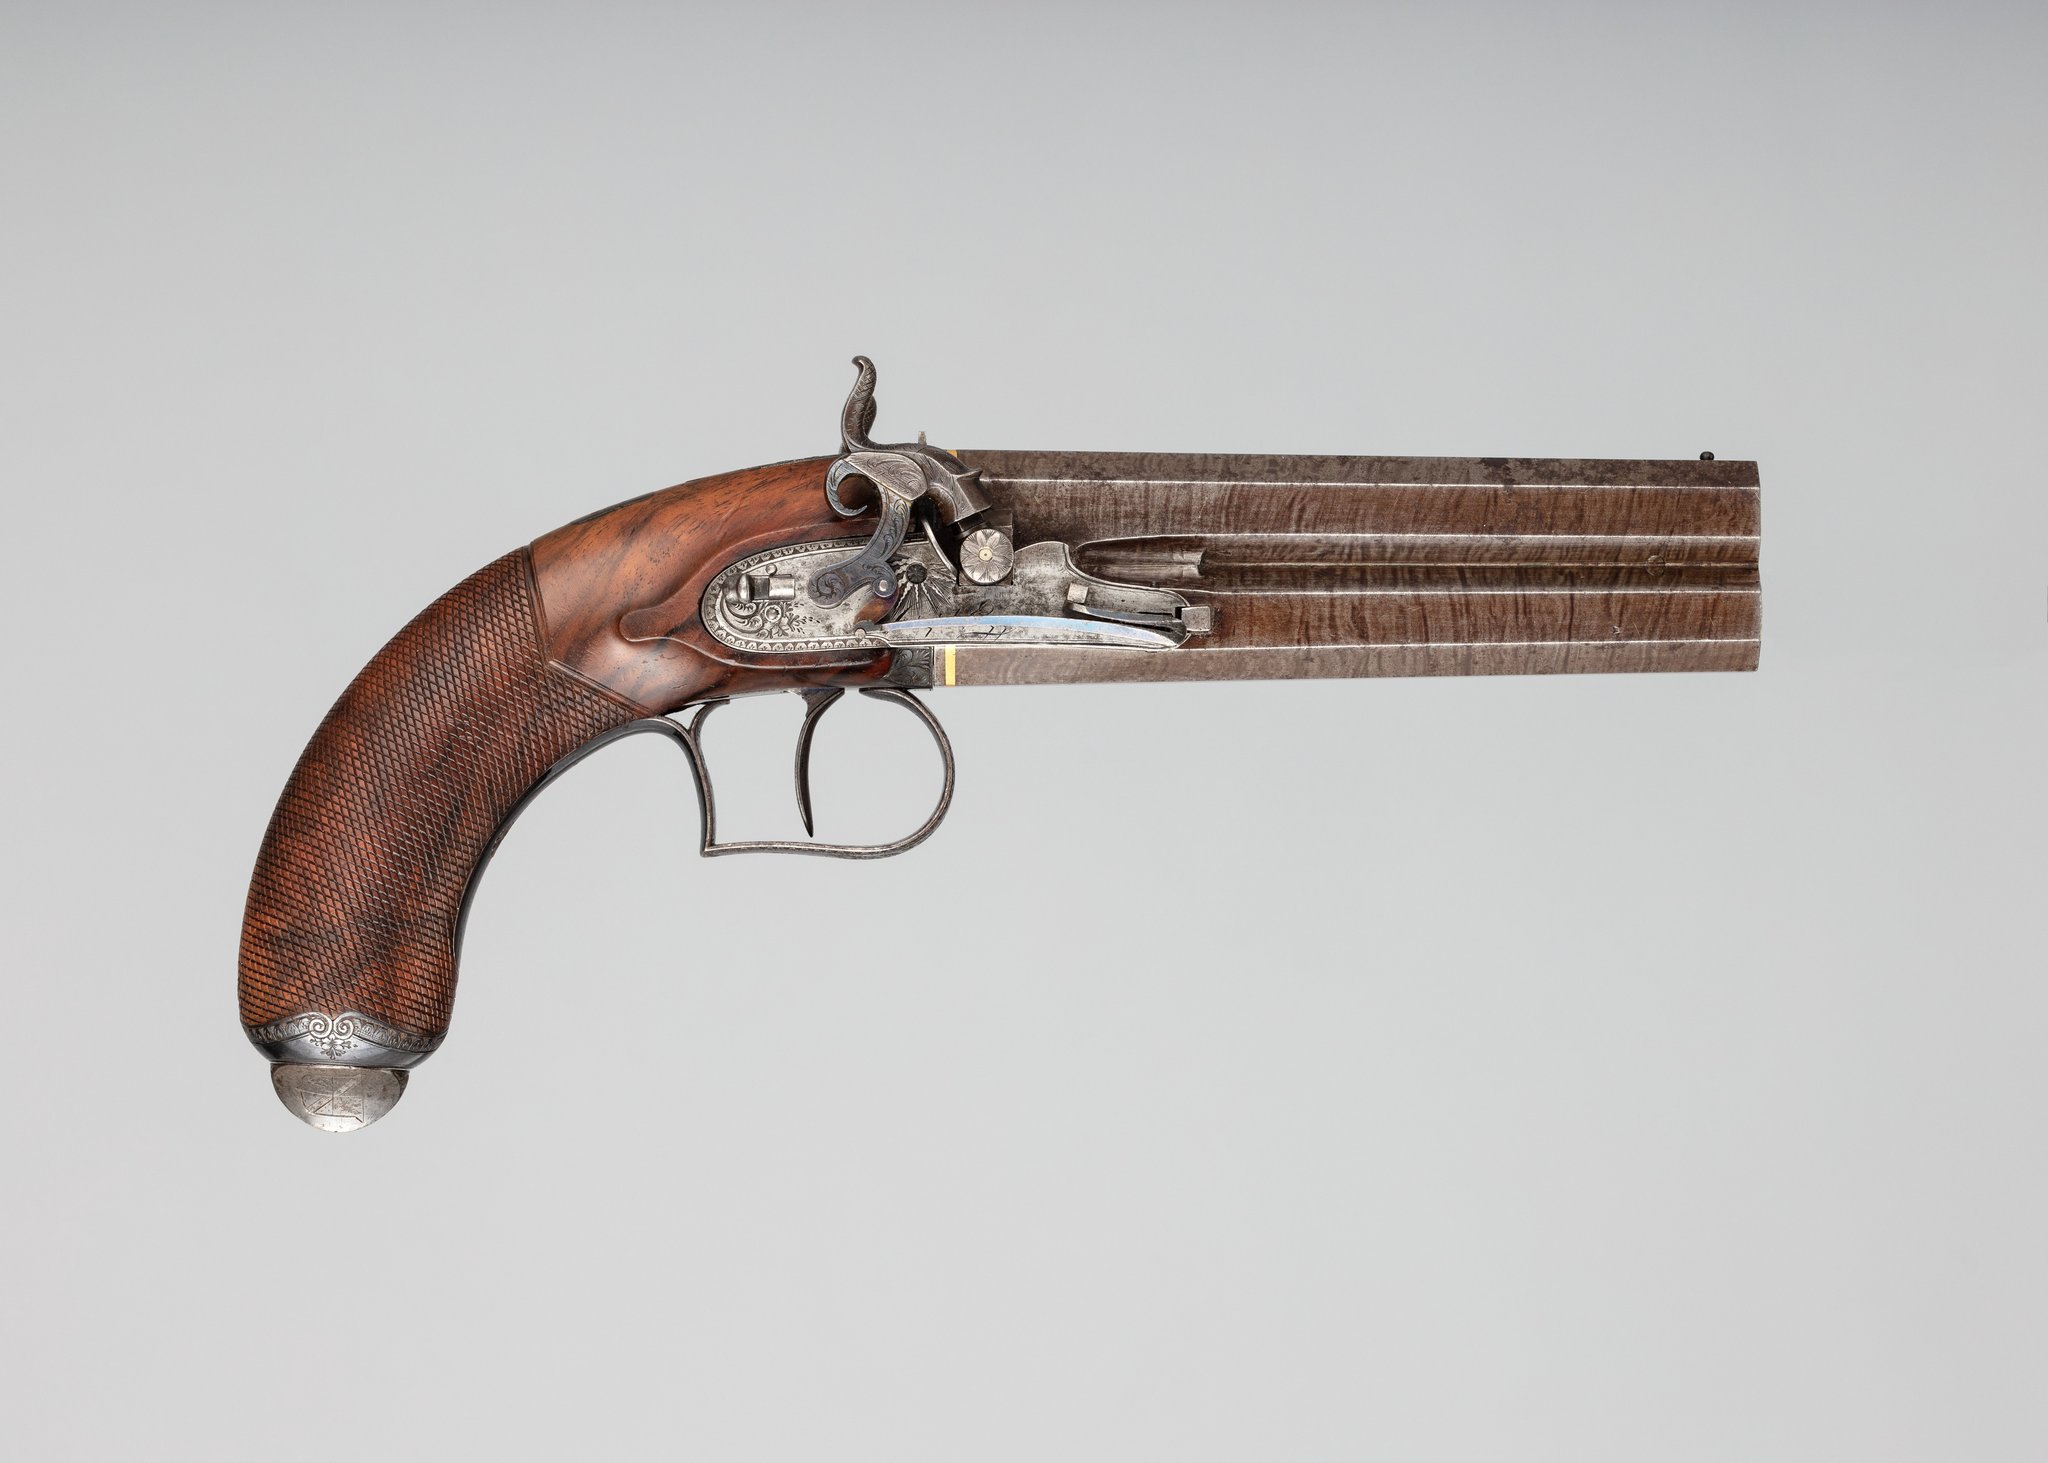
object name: percussion pistol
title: Over-and-Under Percussion Pistol bearing the Crest of the Polhill Family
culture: british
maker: joseph egg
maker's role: gunsmith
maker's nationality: british, born france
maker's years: 1775-1837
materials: brass, gold, platinum, steel, wood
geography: england